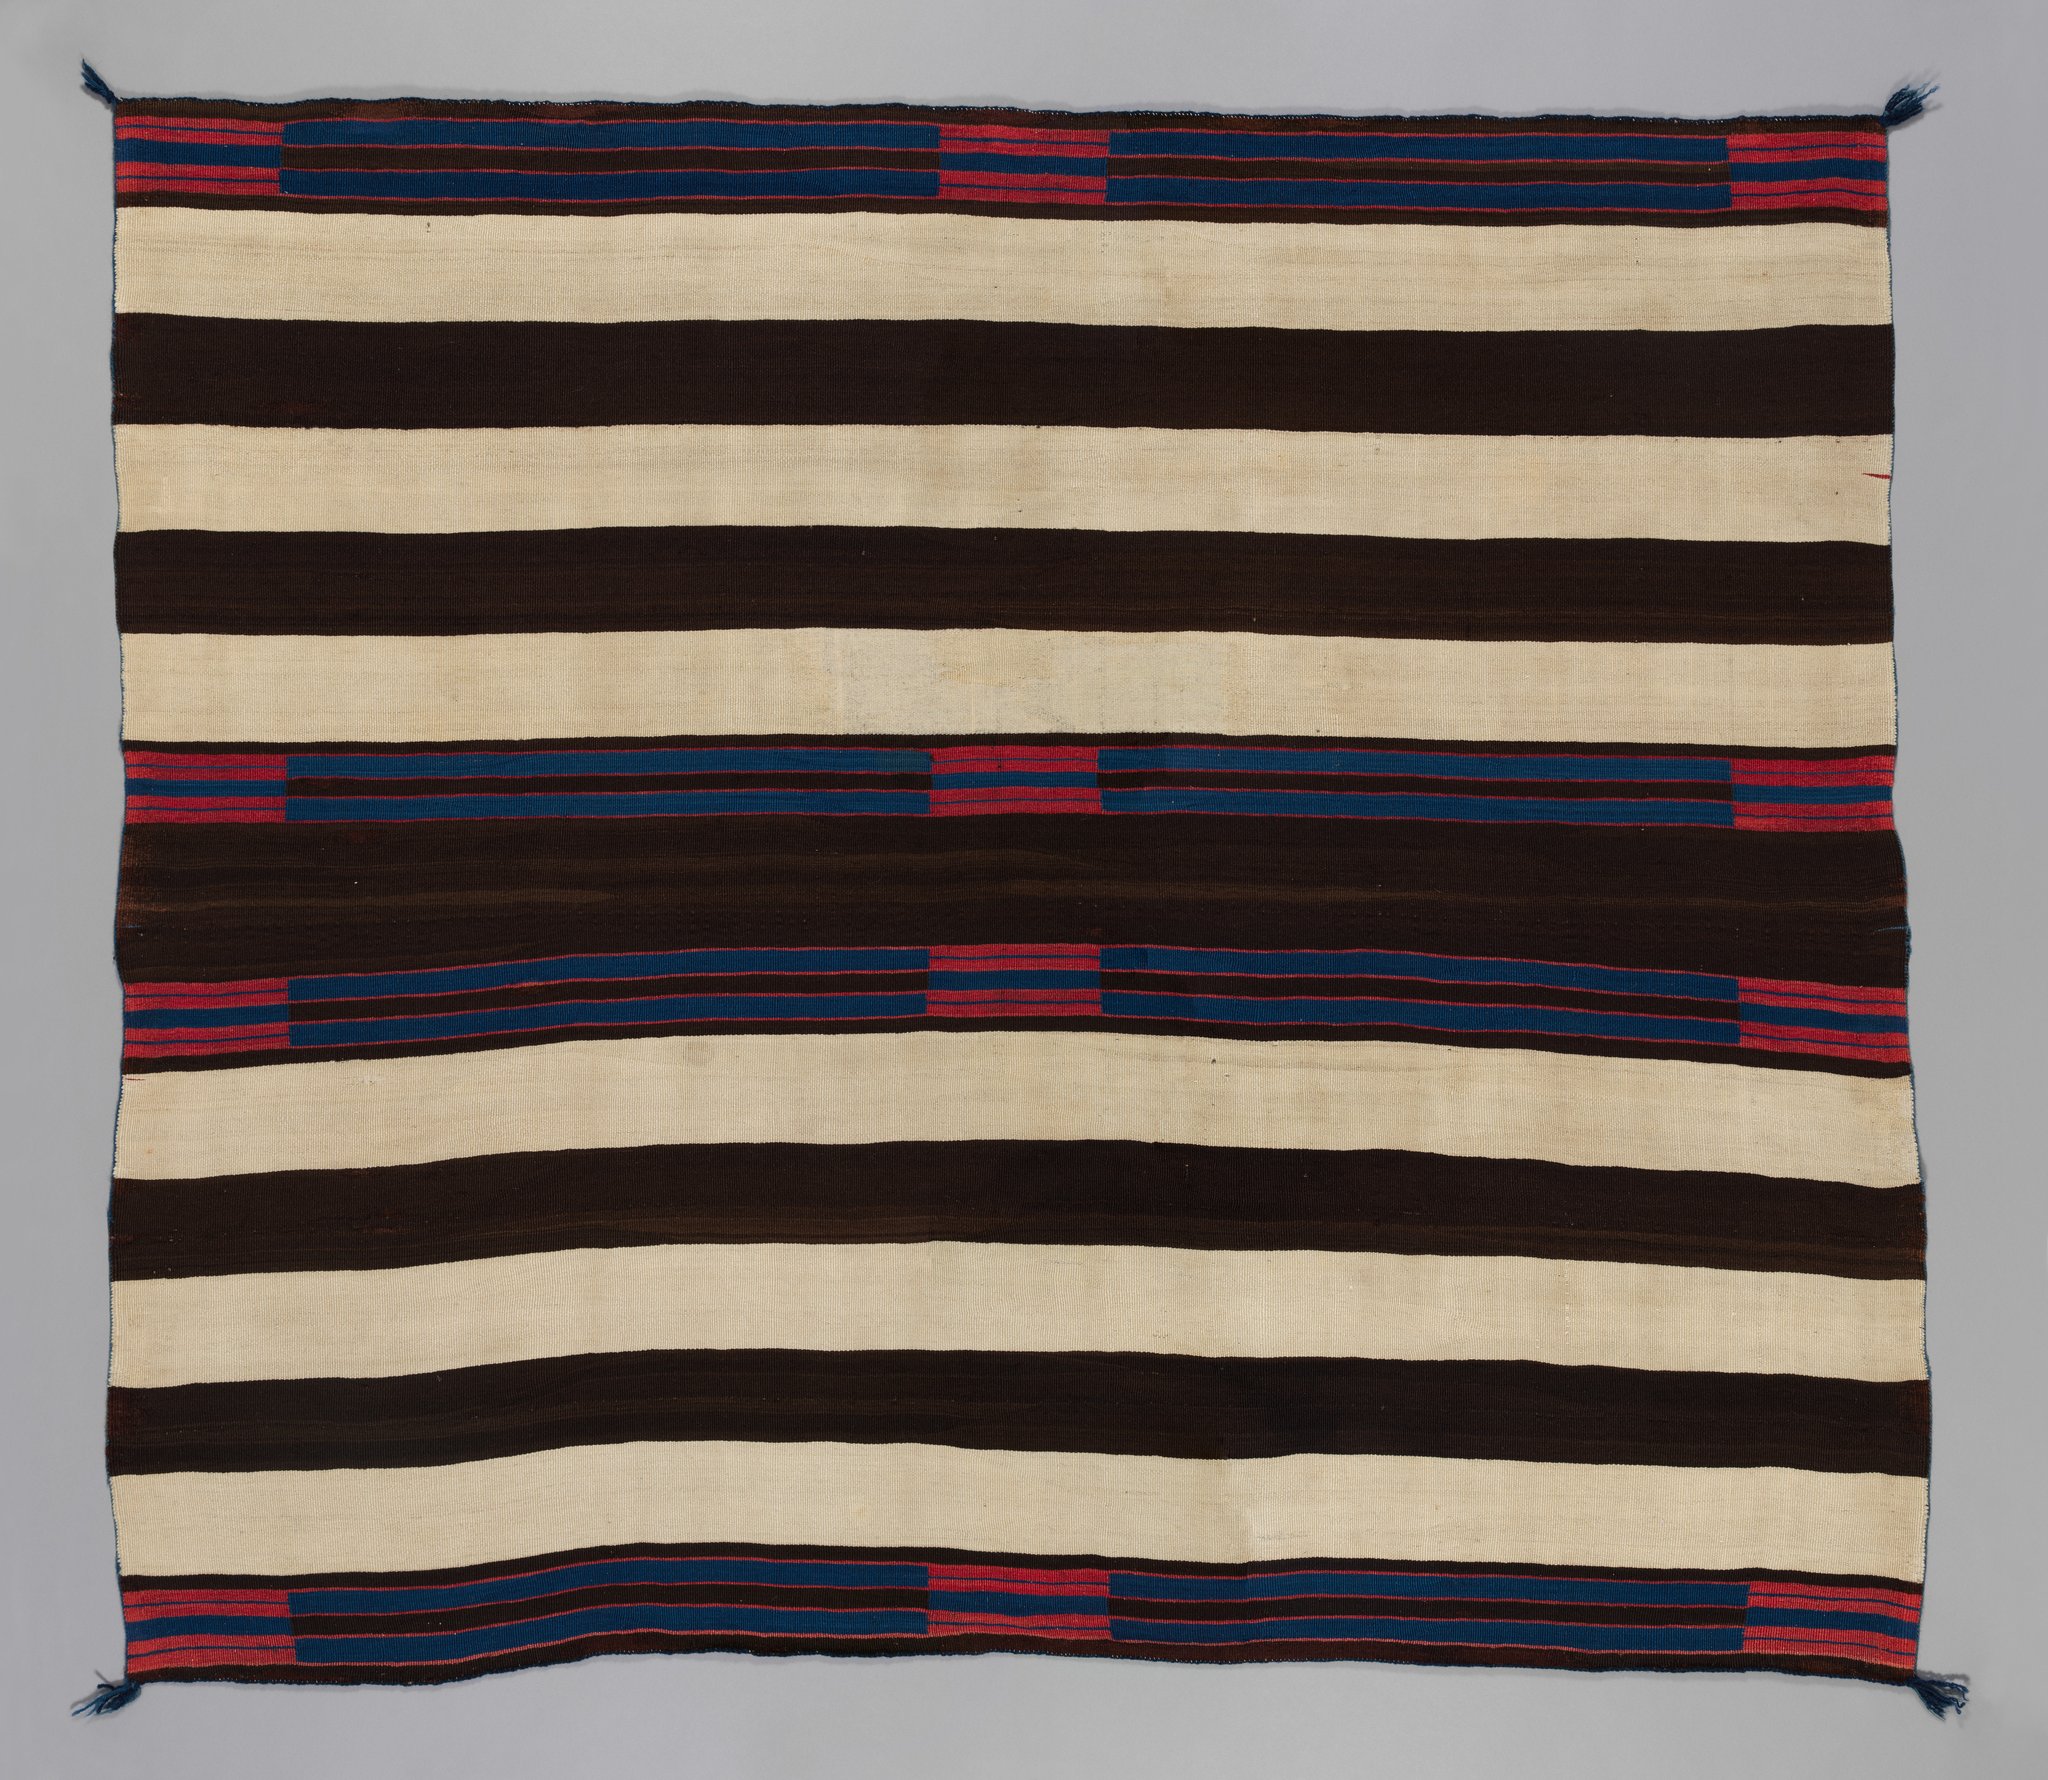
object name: blanket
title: Chief's blanket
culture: diné or navajo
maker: unidentified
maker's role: artist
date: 1855-1860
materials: wool